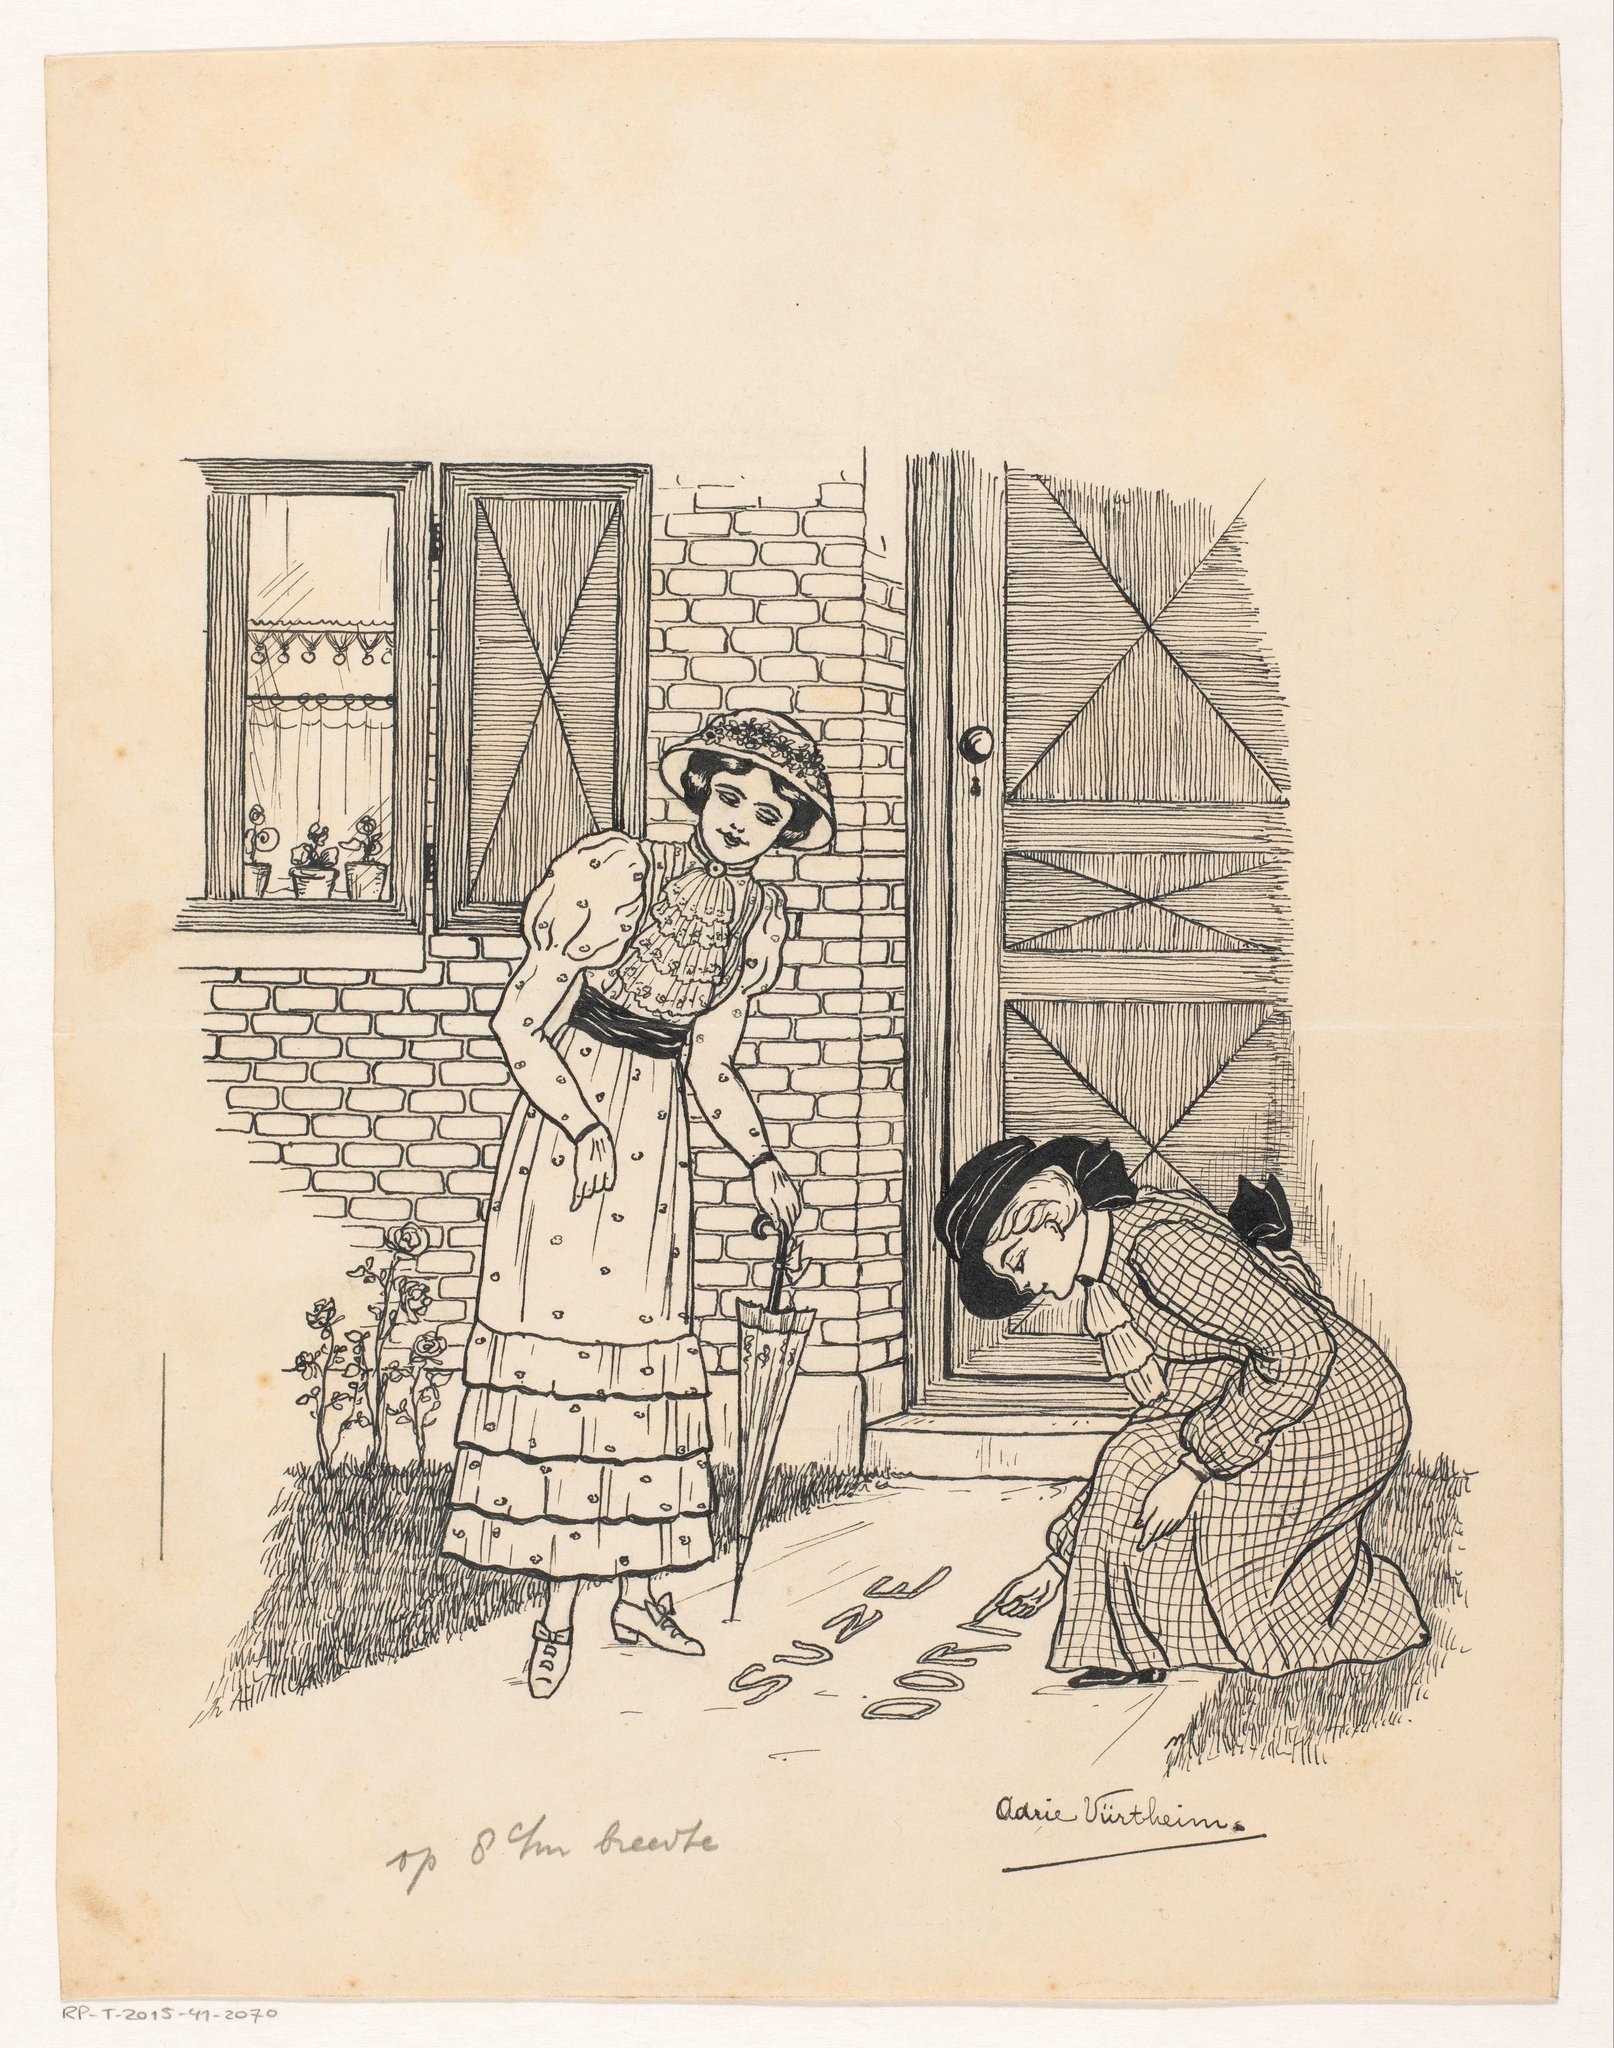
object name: boekillustratie ontwerp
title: Vrouw schrijft haar naam op een pad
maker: adrie vürtheim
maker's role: draughtsman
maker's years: 1907-1995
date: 1917-1970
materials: ink, paper, pencil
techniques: brush, pen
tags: handwriting, written text, road, path, door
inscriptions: signature: ‘Adrie Vürtheim.’, :, collector's mark: Lugt 2228a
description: Een vrouw met een paraplu staat op een pad bij de voordeur van een huis. Ze kijkt naar een jonge vrouw die geknield op het pad zit en met haar vinger haar naam in de (zand)grond schrijft.